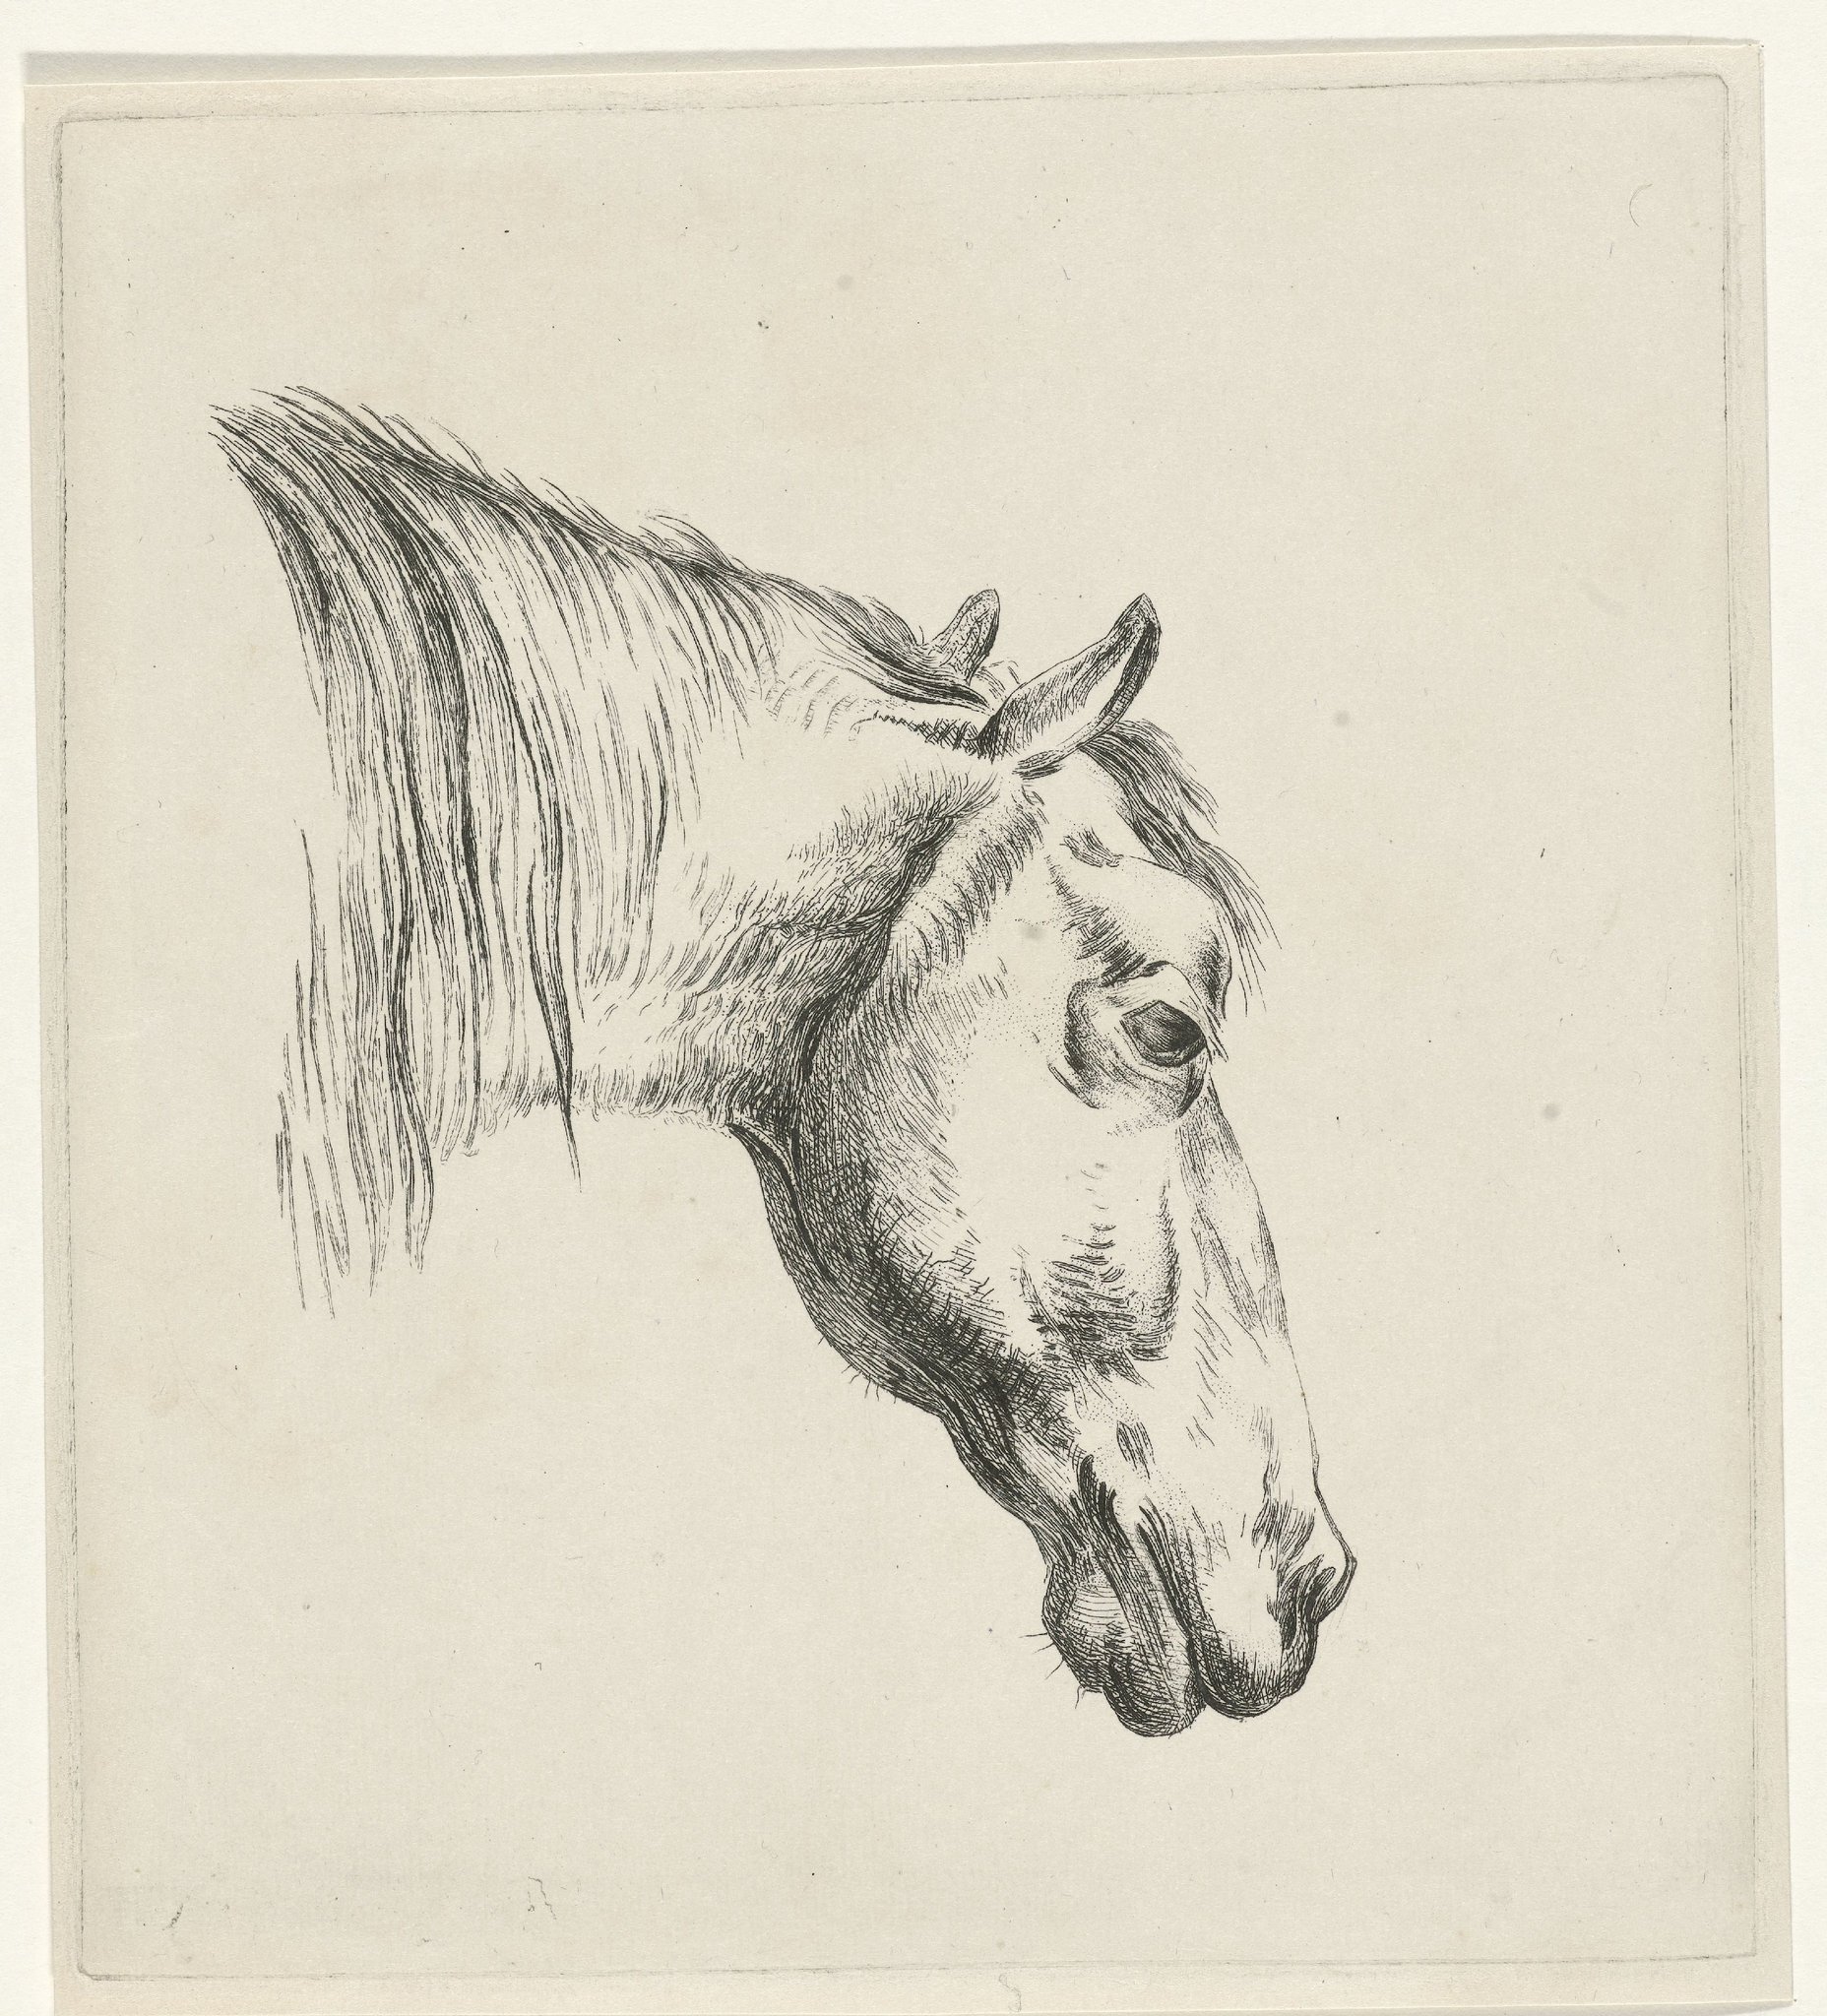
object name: print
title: Hoofd van een paard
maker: reinierus albertus ludovicus baron van isendoorn à blois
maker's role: print maker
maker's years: 1786-1856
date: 1796-1856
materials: paper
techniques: etching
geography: vaassen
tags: horse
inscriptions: collector's mark: Lugt 2228